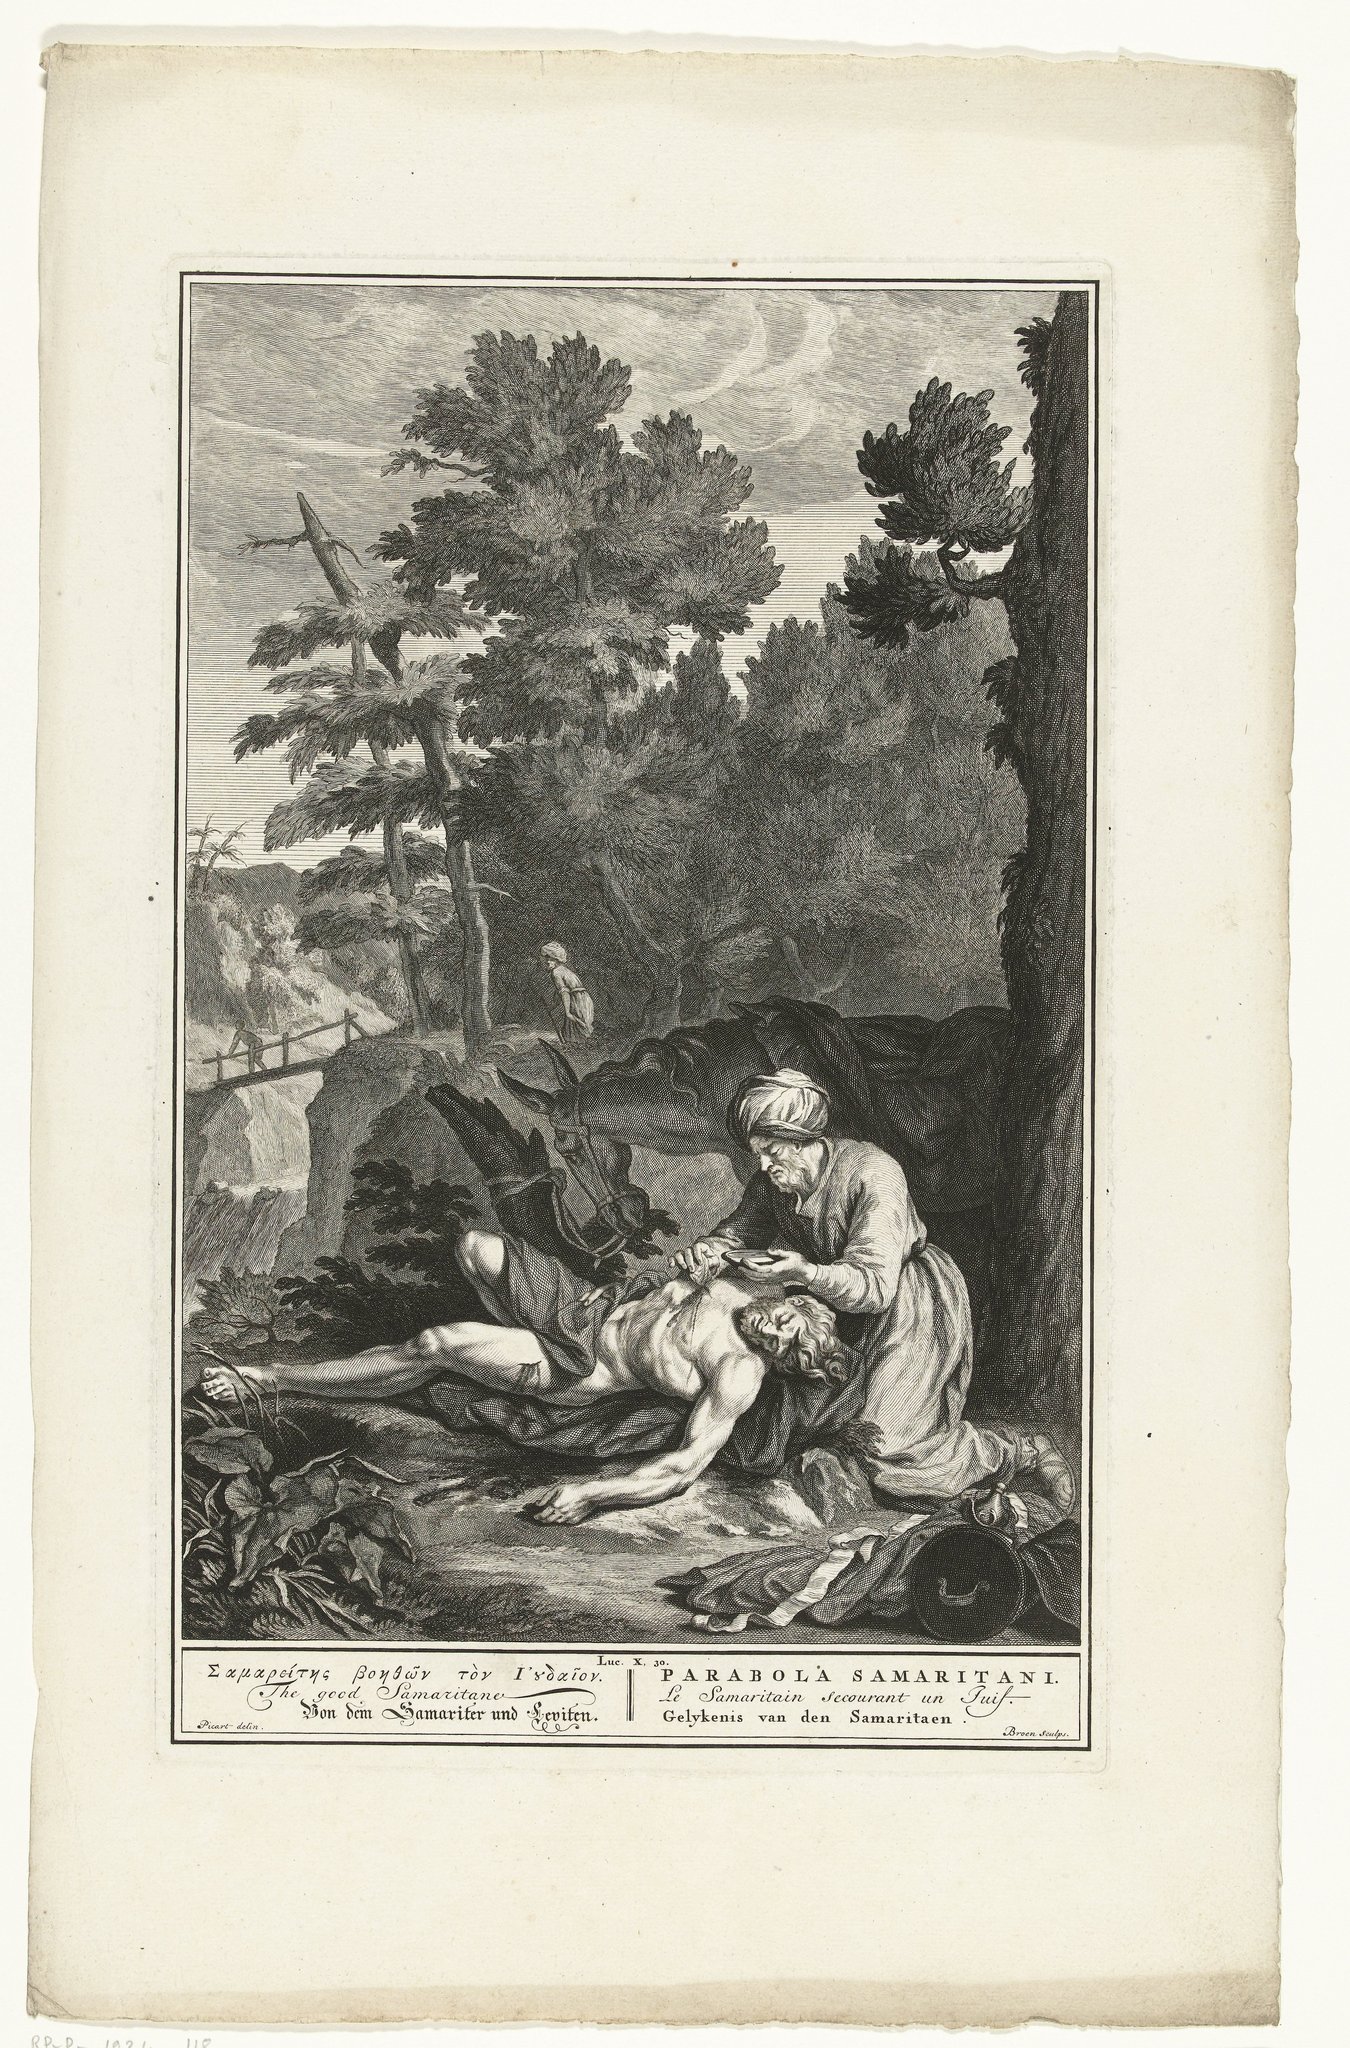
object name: book illustration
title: Gelykenis van den Samaritaan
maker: bernard picart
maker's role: draughtsman, print maker, publisher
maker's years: 1673-1733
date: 1711-1720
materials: paper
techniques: engraving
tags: a samaritan tending the wounds of the traveller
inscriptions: inscription: ‘Utrechts Fundatie huys’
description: De barmhartige Samaritaan verzorgt de wond van de door rovers aangevallen reiziger. Op de achtergrond is de priester te zien die de man langs de kant van de weg liet liggen zonder hem te helpen. Illustratie voor het Nieuwe Testament, Luc. 10, 30. Onder de voorstelling een titel in het Grieks, Engels, Duits, Latijn, Frans en Nederlands.